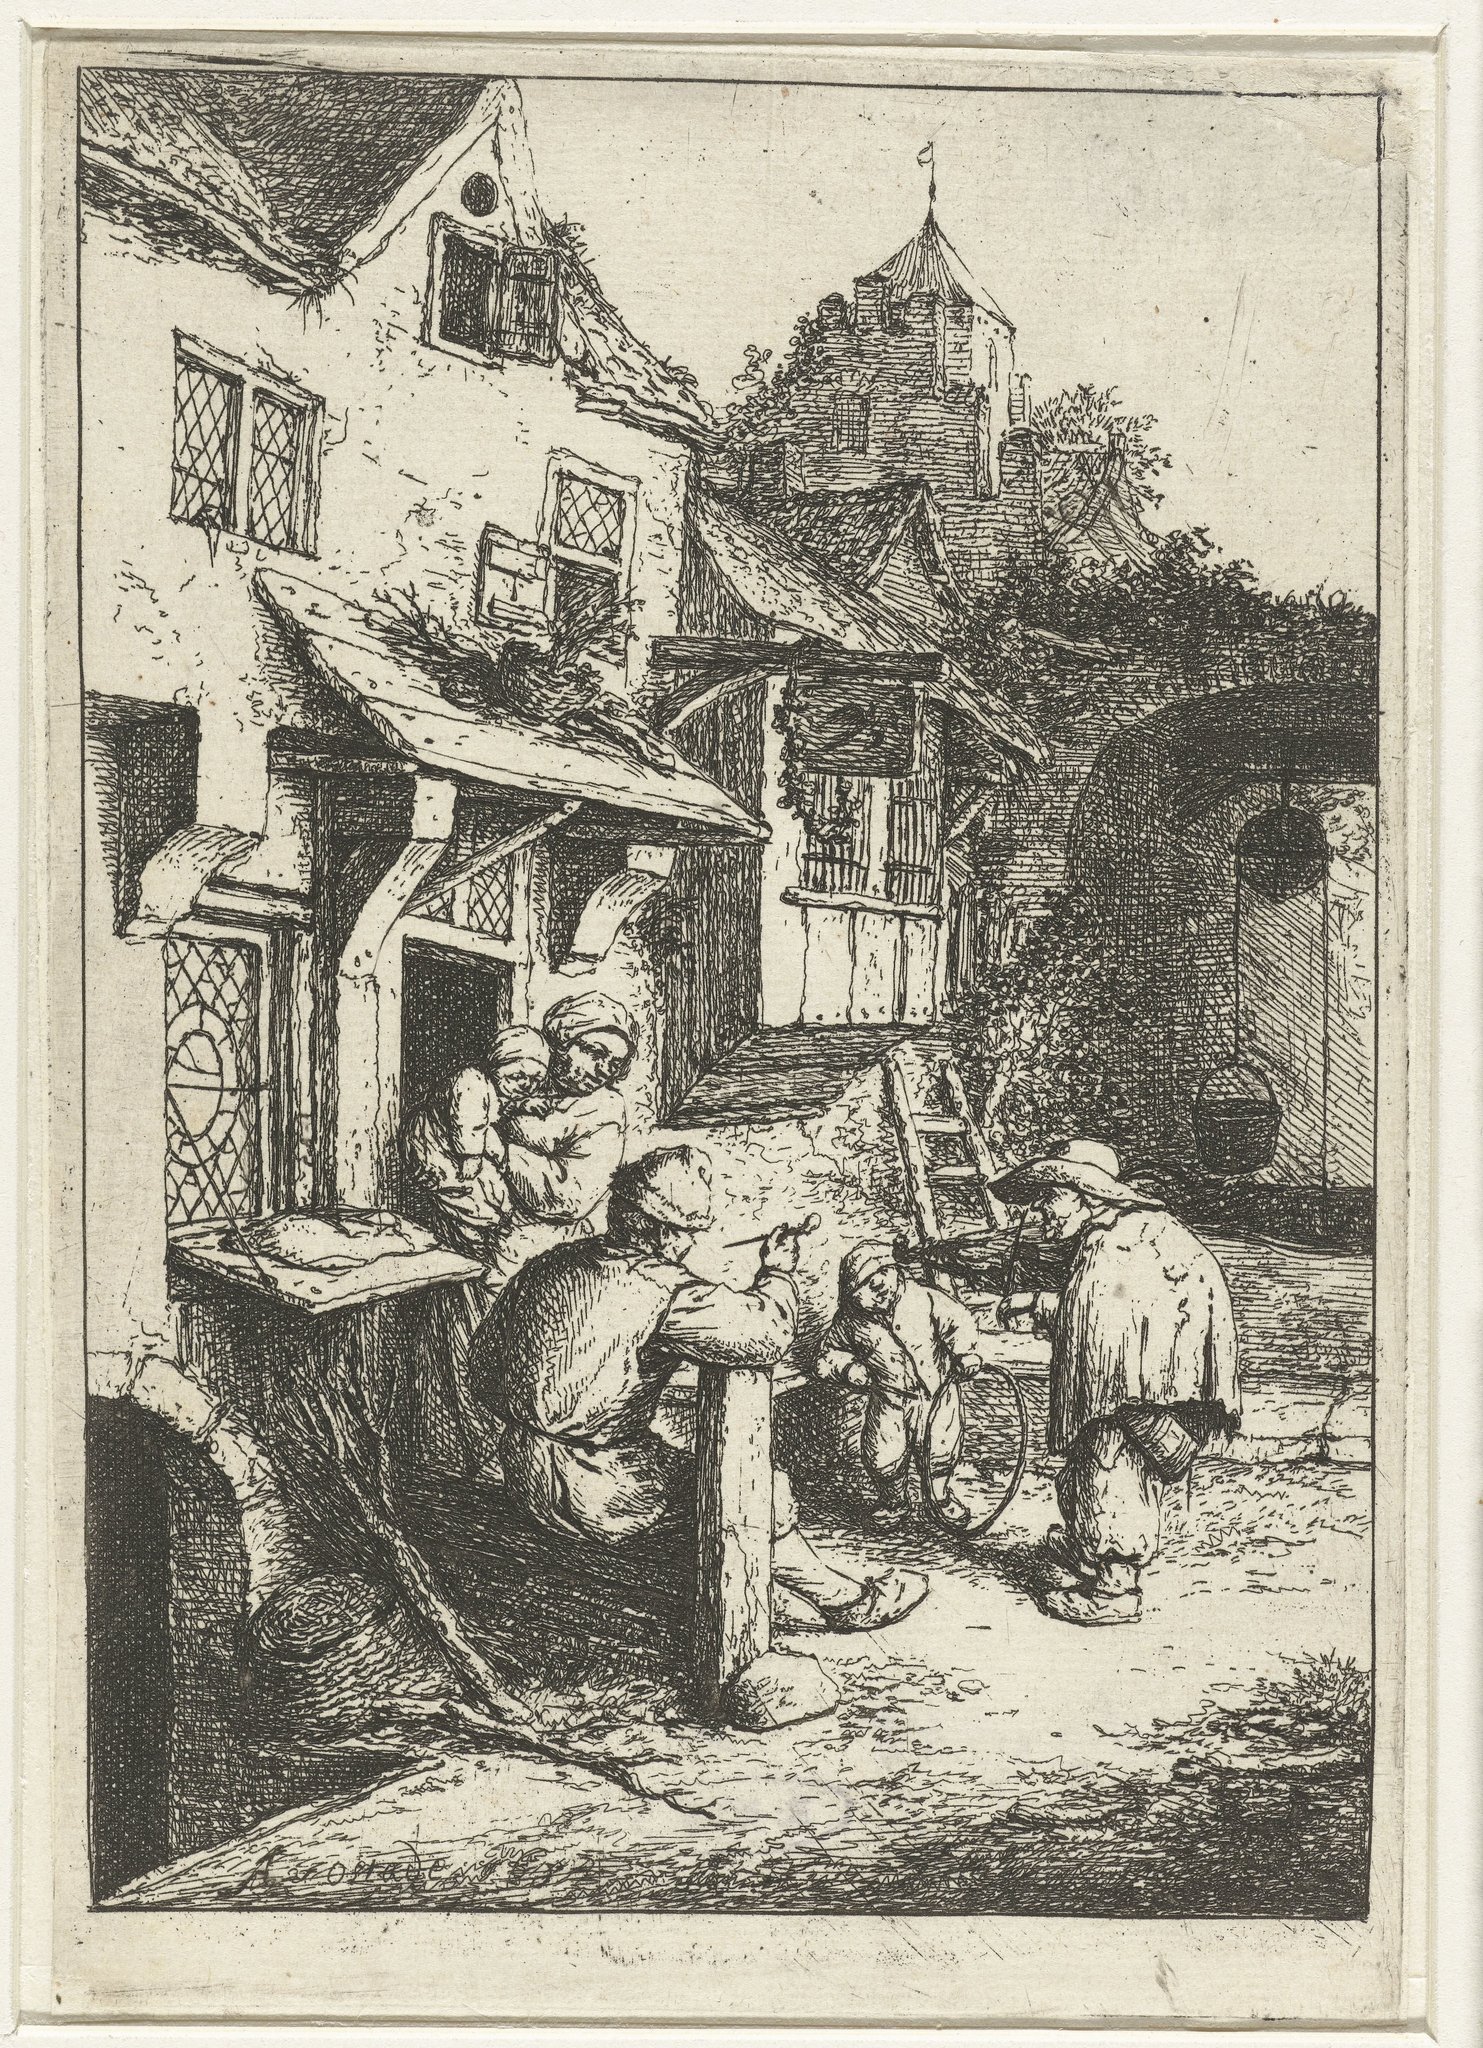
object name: print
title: Gebochelde vioolspeler voor een herberg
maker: adriaen van ostade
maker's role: draughtsman, painter, print maker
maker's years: 1610-1685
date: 1652-1656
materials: paper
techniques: etching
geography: haarlem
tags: one person playing string instrument (bowed), inn, coffee-house, public house, etc.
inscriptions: collector's mark: Lugt 964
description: Een kleine man met een kromme rug speelt viool voor de ingang van een herberg. In de deuropening staat een vrouw met een klein kind op haar arm. Op een hekje rookt een man een pijp en een kleine jongen staat met een hoepel in zijn hand te luisteren.